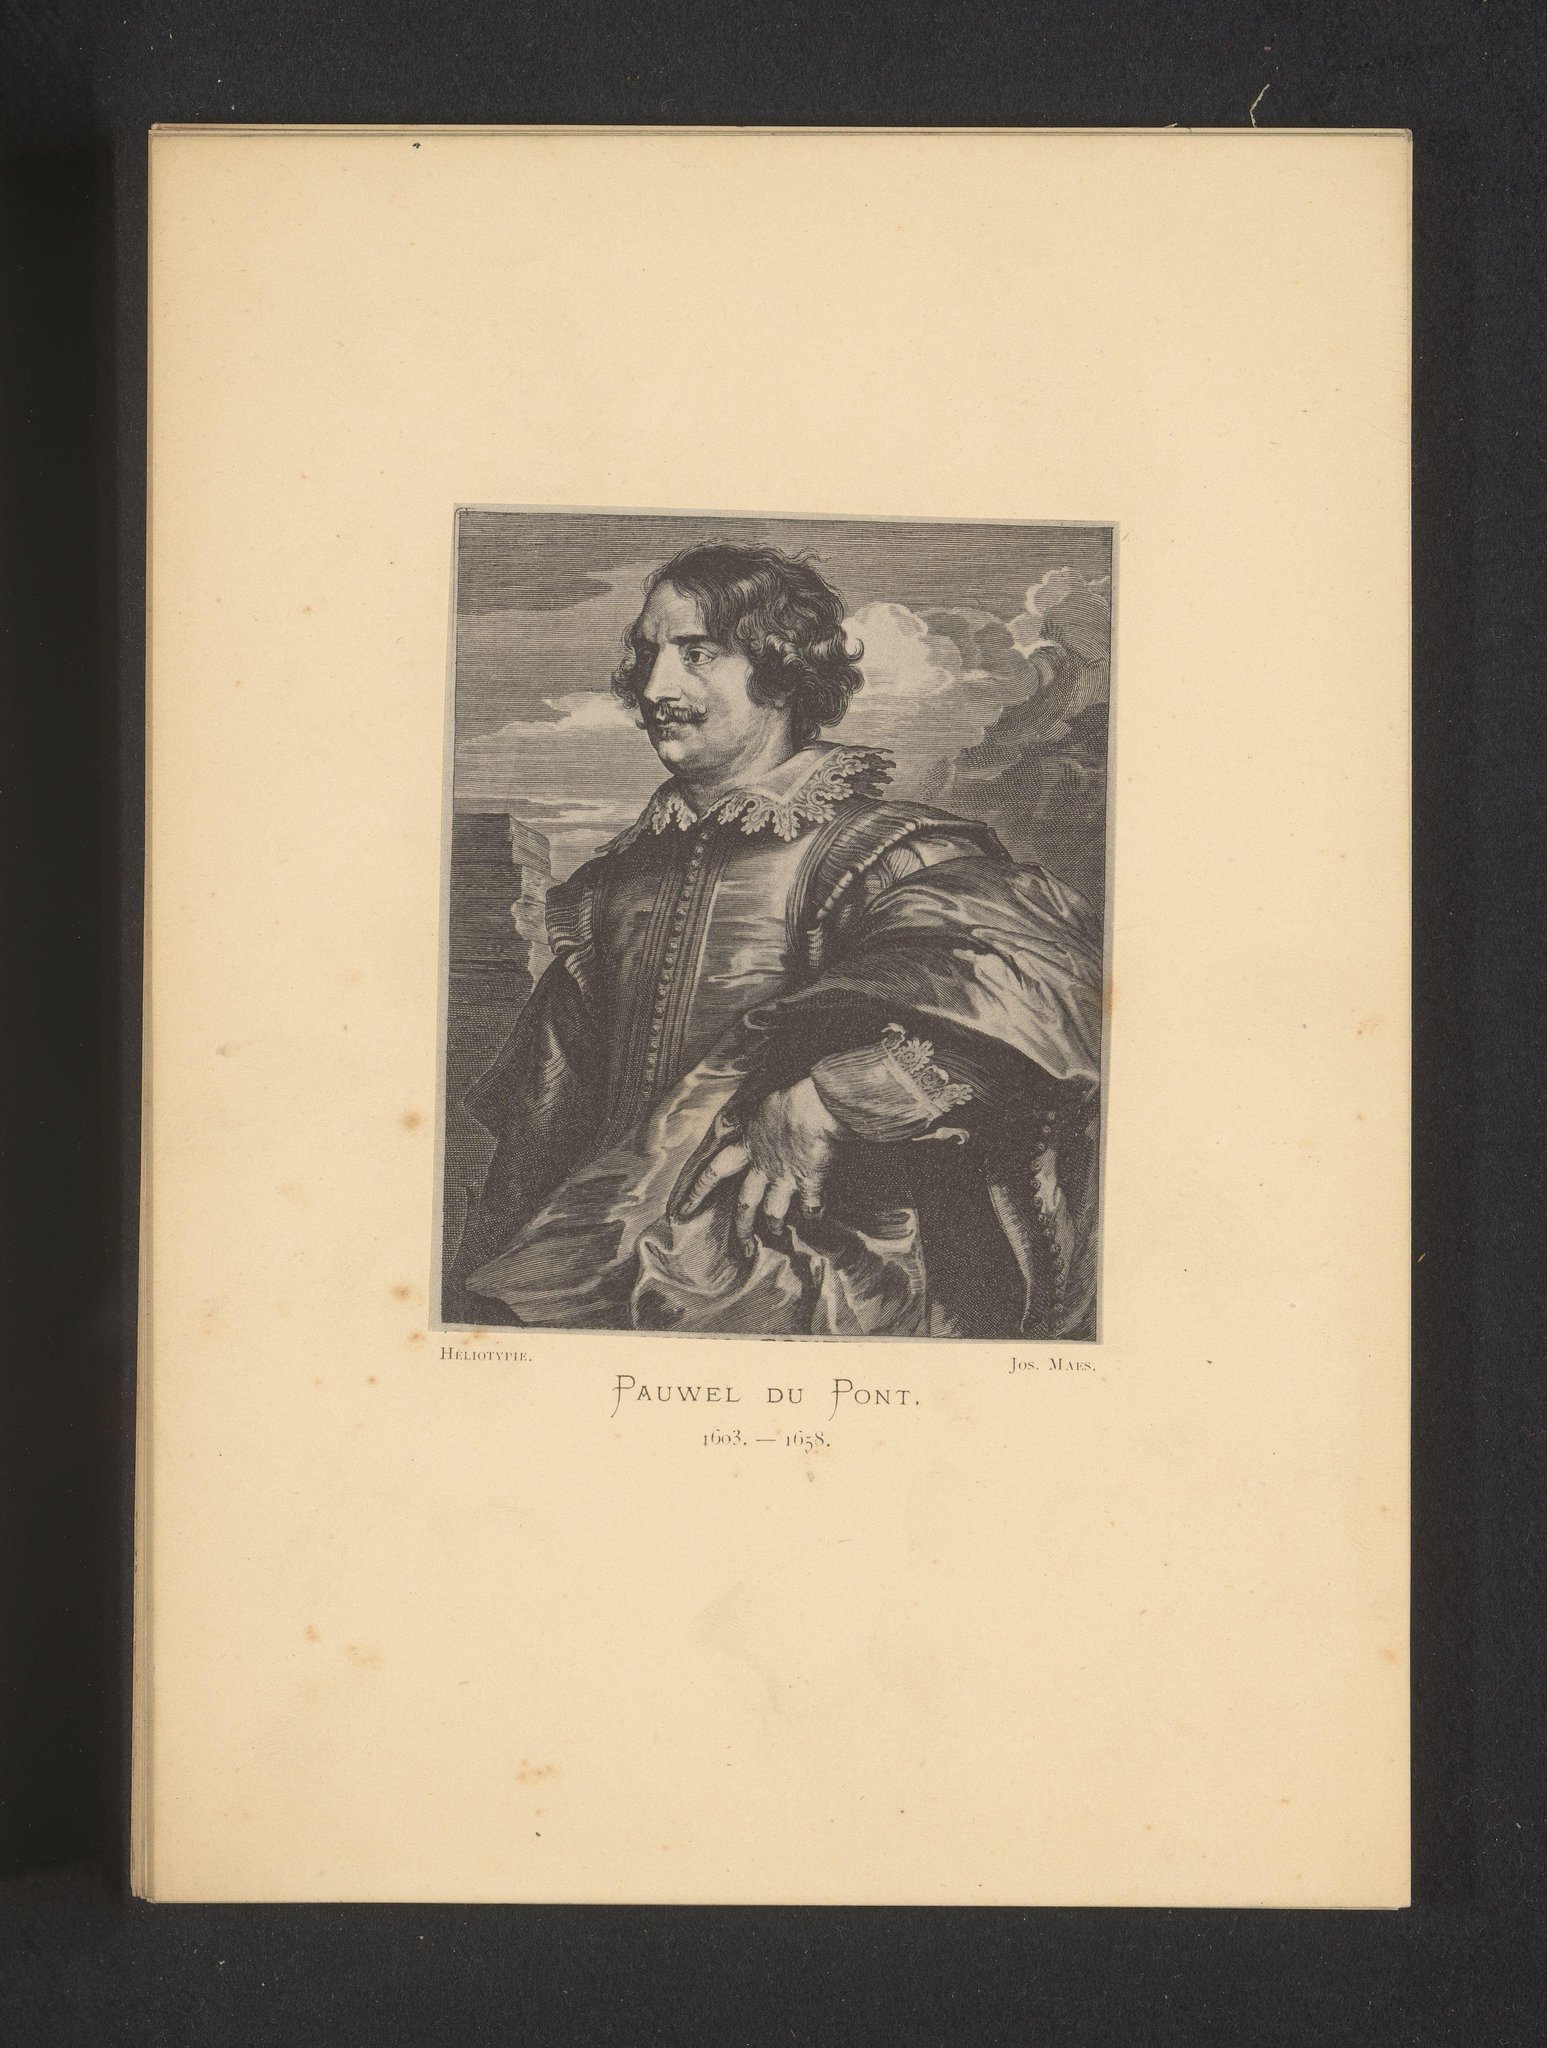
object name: photomechanical print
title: Pauwel du Pont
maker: joseph maes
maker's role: fotograaf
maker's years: 1838-1908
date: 1872-1877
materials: cardboard, paper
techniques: photograph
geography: antwerp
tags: draughtsman, paulus pontius, historical persons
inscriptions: inscription: ‘1603. - 1658.’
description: Deze prent maakt deel uit van een omslag met 150 prenten en een katern met een lijst van afbeeldingen.